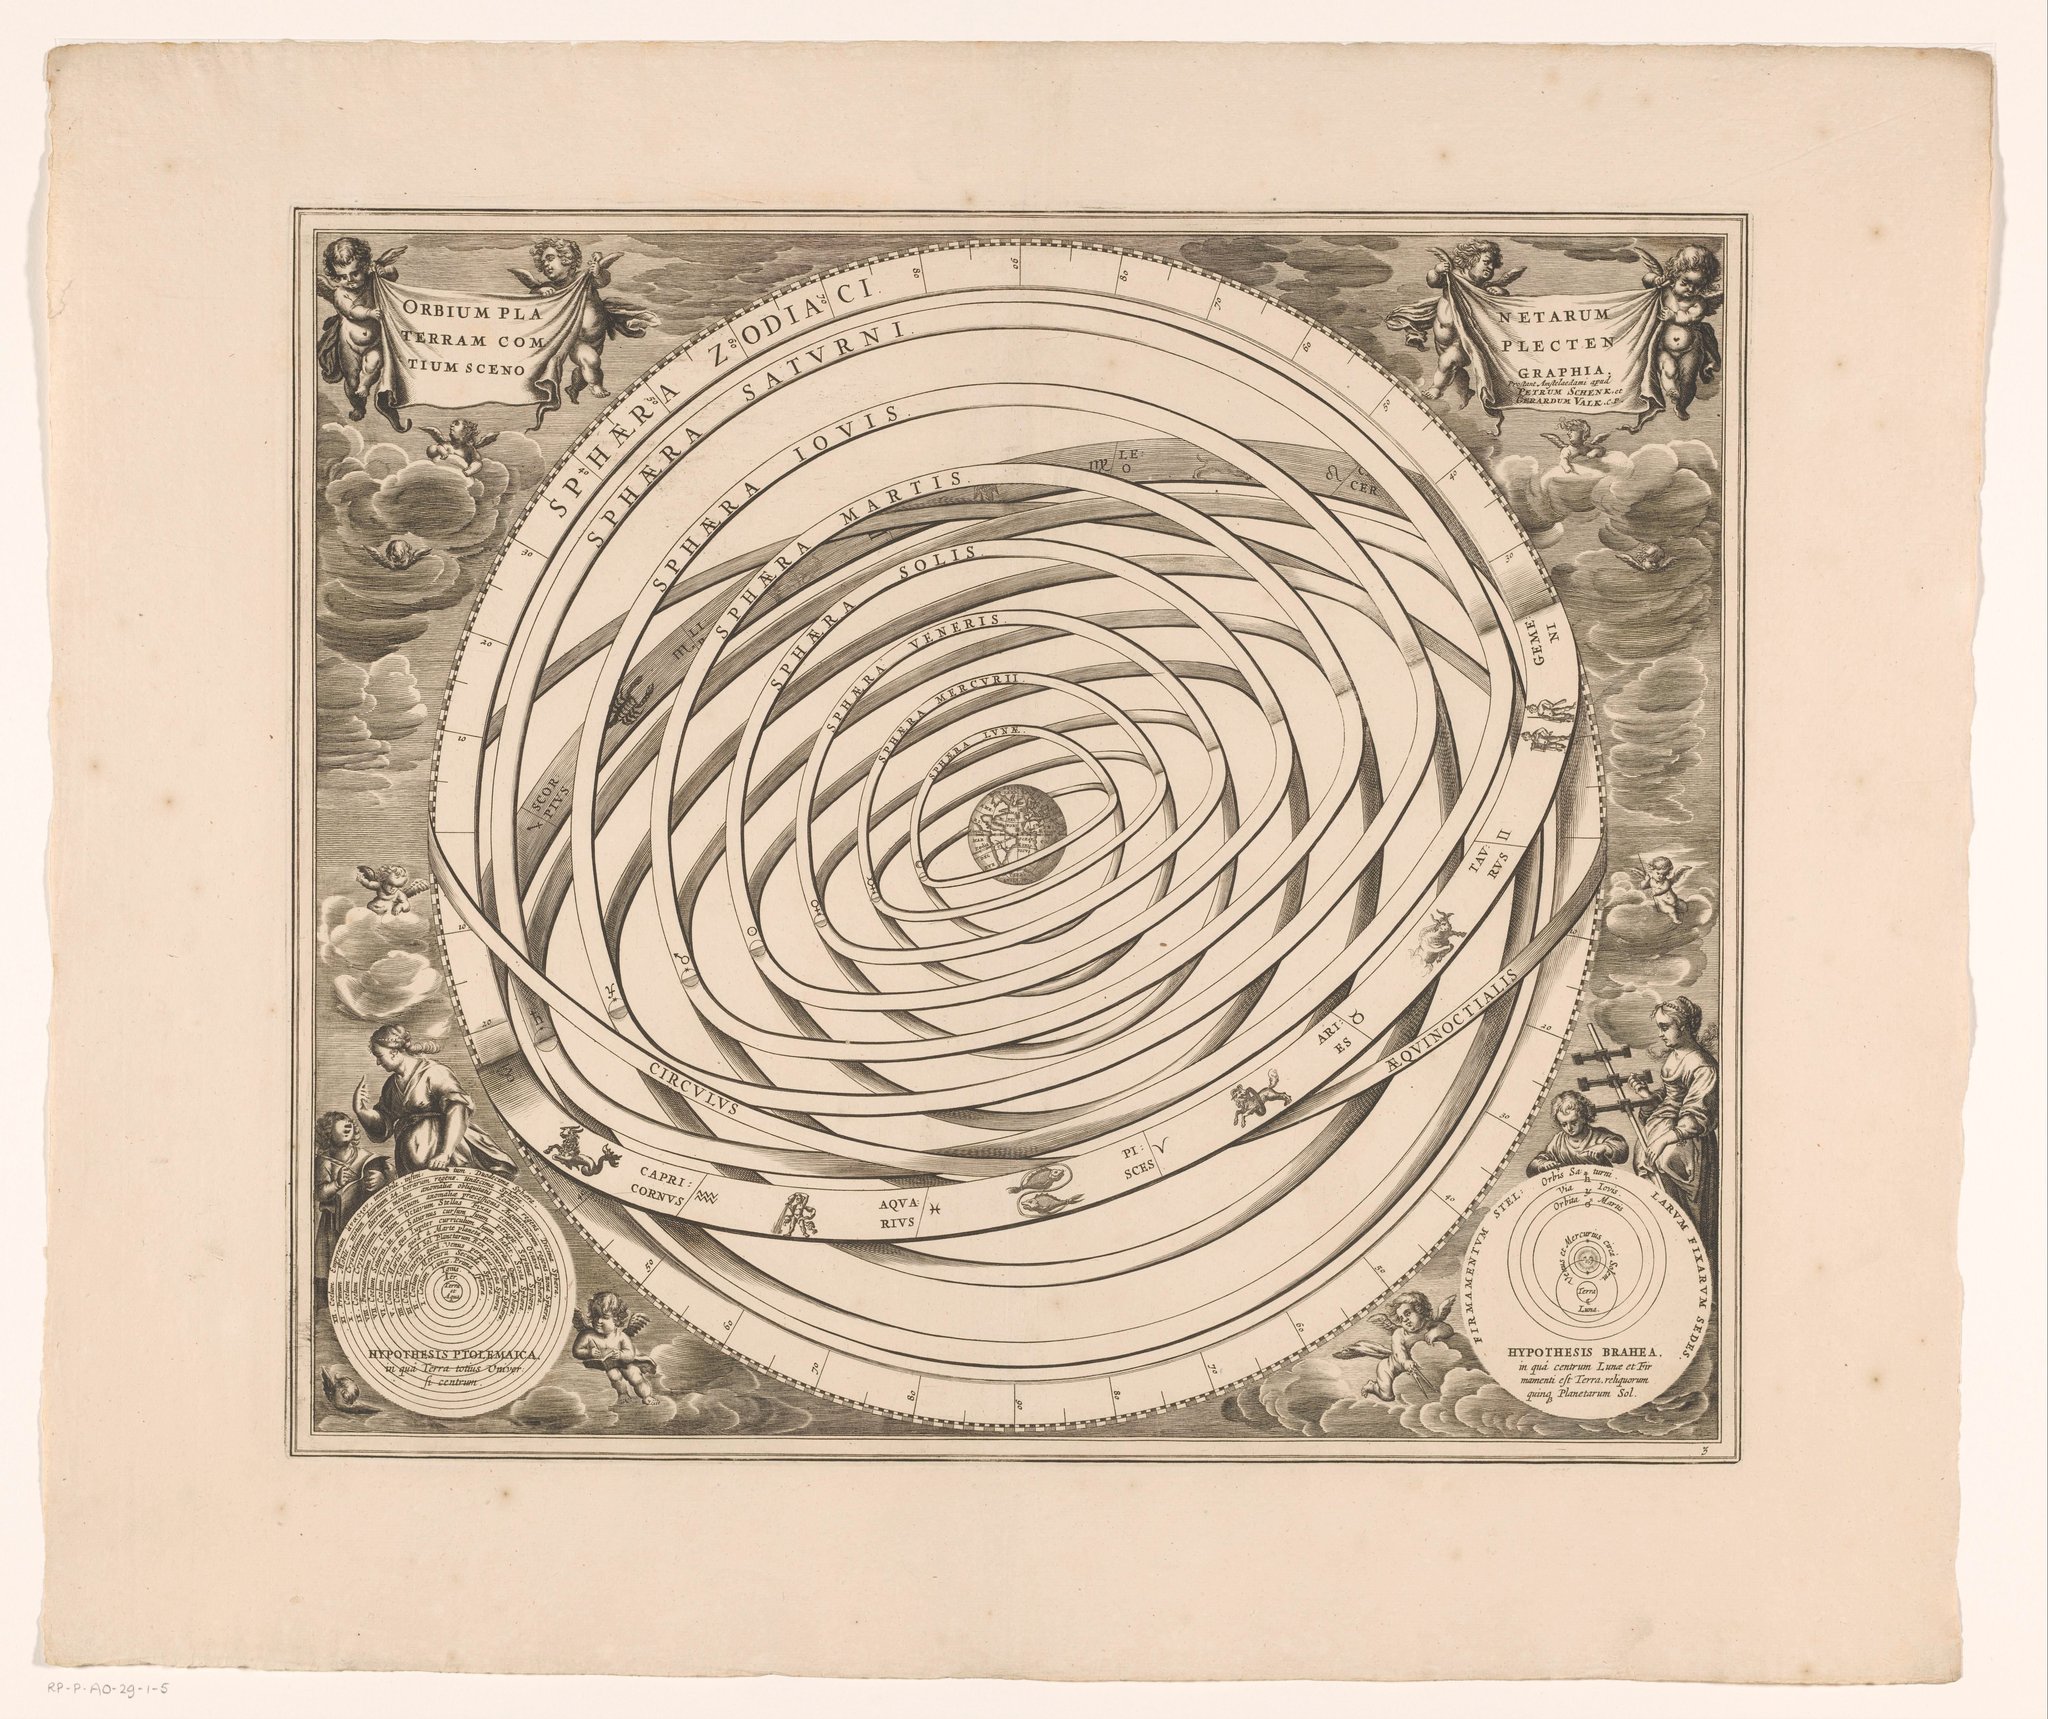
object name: map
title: Orbium planetarum terram complectentium scenographia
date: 1660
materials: paper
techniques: engraving, etching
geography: amsterdam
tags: zodiac; the twelve zodiacal signs together, star-chart, star map, planets; planetary system, solar system, instruments used in geodesy, surveying instruments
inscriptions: collector's mark: Lugt 2228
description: Hemelkaart waar het geocentrische stelsel van Ptolemaeus op te zien is. In het midden de aarde, met daaromheen de dierenriem en de banen van de planeten, de maan en de zon. De kaart is voorzien van een gradenverdeling langs de randen. Links- en rechtsboven een titelcartouche, gedragen door putti. Linksonder een bol met daarin een kleine weergave van het stelsel van Ptolemaeus, rechtsonder een bol met kleine weergave van het stelsel van Tycho Brahe. Rechtsonder genummerd: 3.